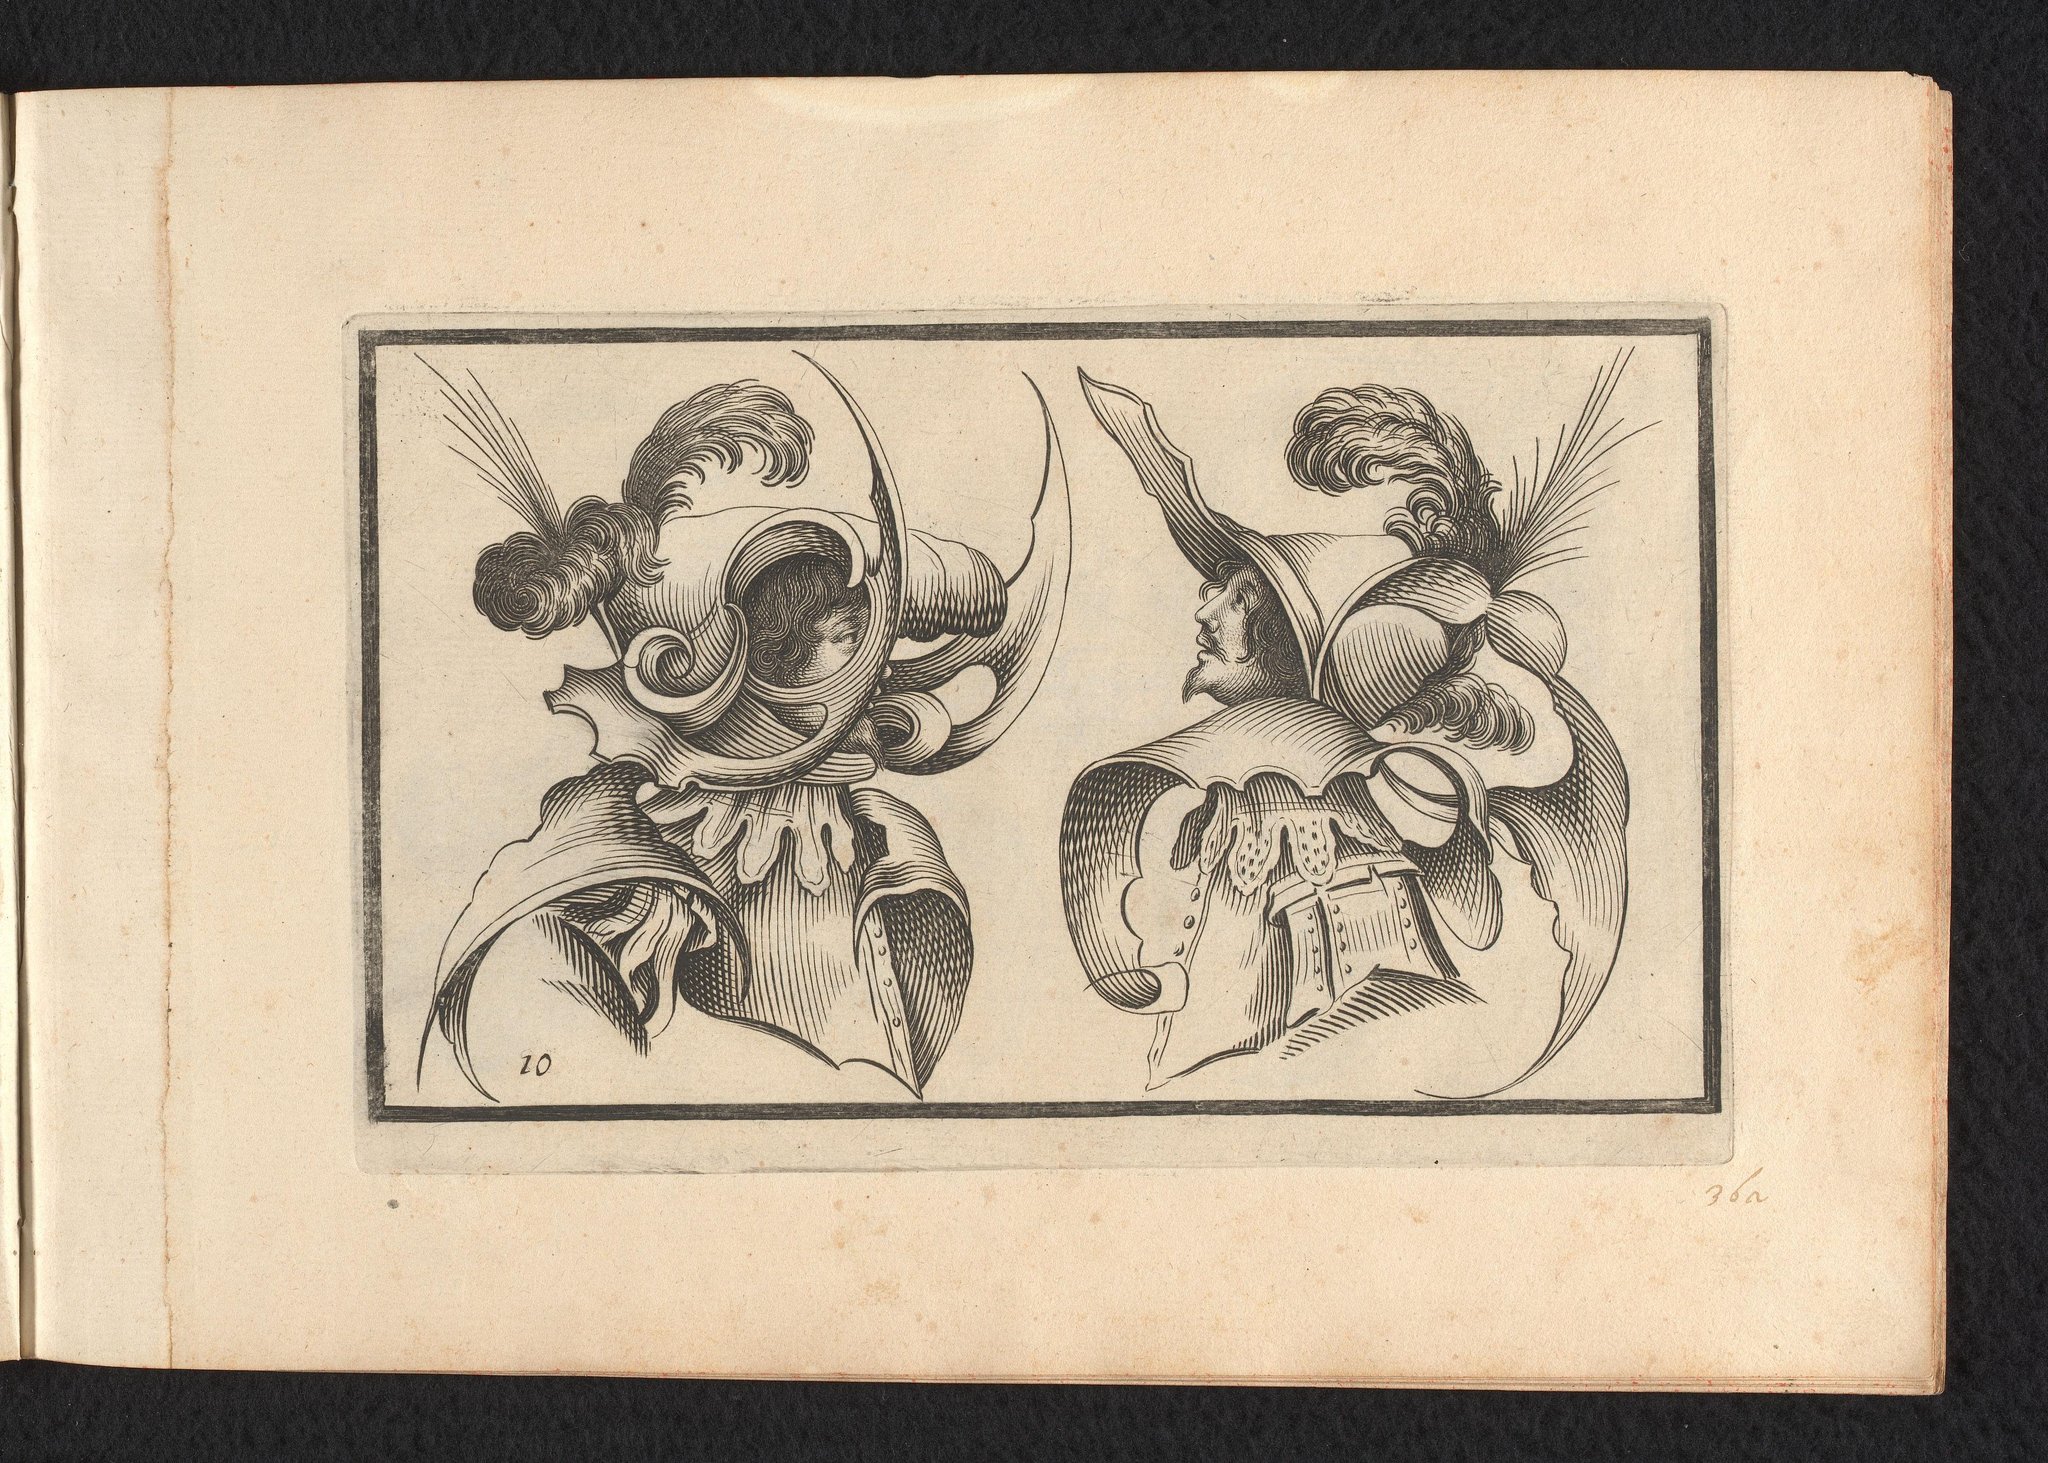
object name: ornament print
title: Ouvrage rare et nouveau, contenant plusieurs desseins de merveilleuse recreation sous diverses caprices et gentillesses representees en l'industrieuse decoupure d'un chappeau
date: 1636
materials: paper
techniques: engraving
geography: paris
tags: ornaments ~ art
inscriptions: collector's mark: Lugt 2760, number: ‘363’, collector's mark: Lugt 2228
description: Deze prent maakt deel uit van een album.